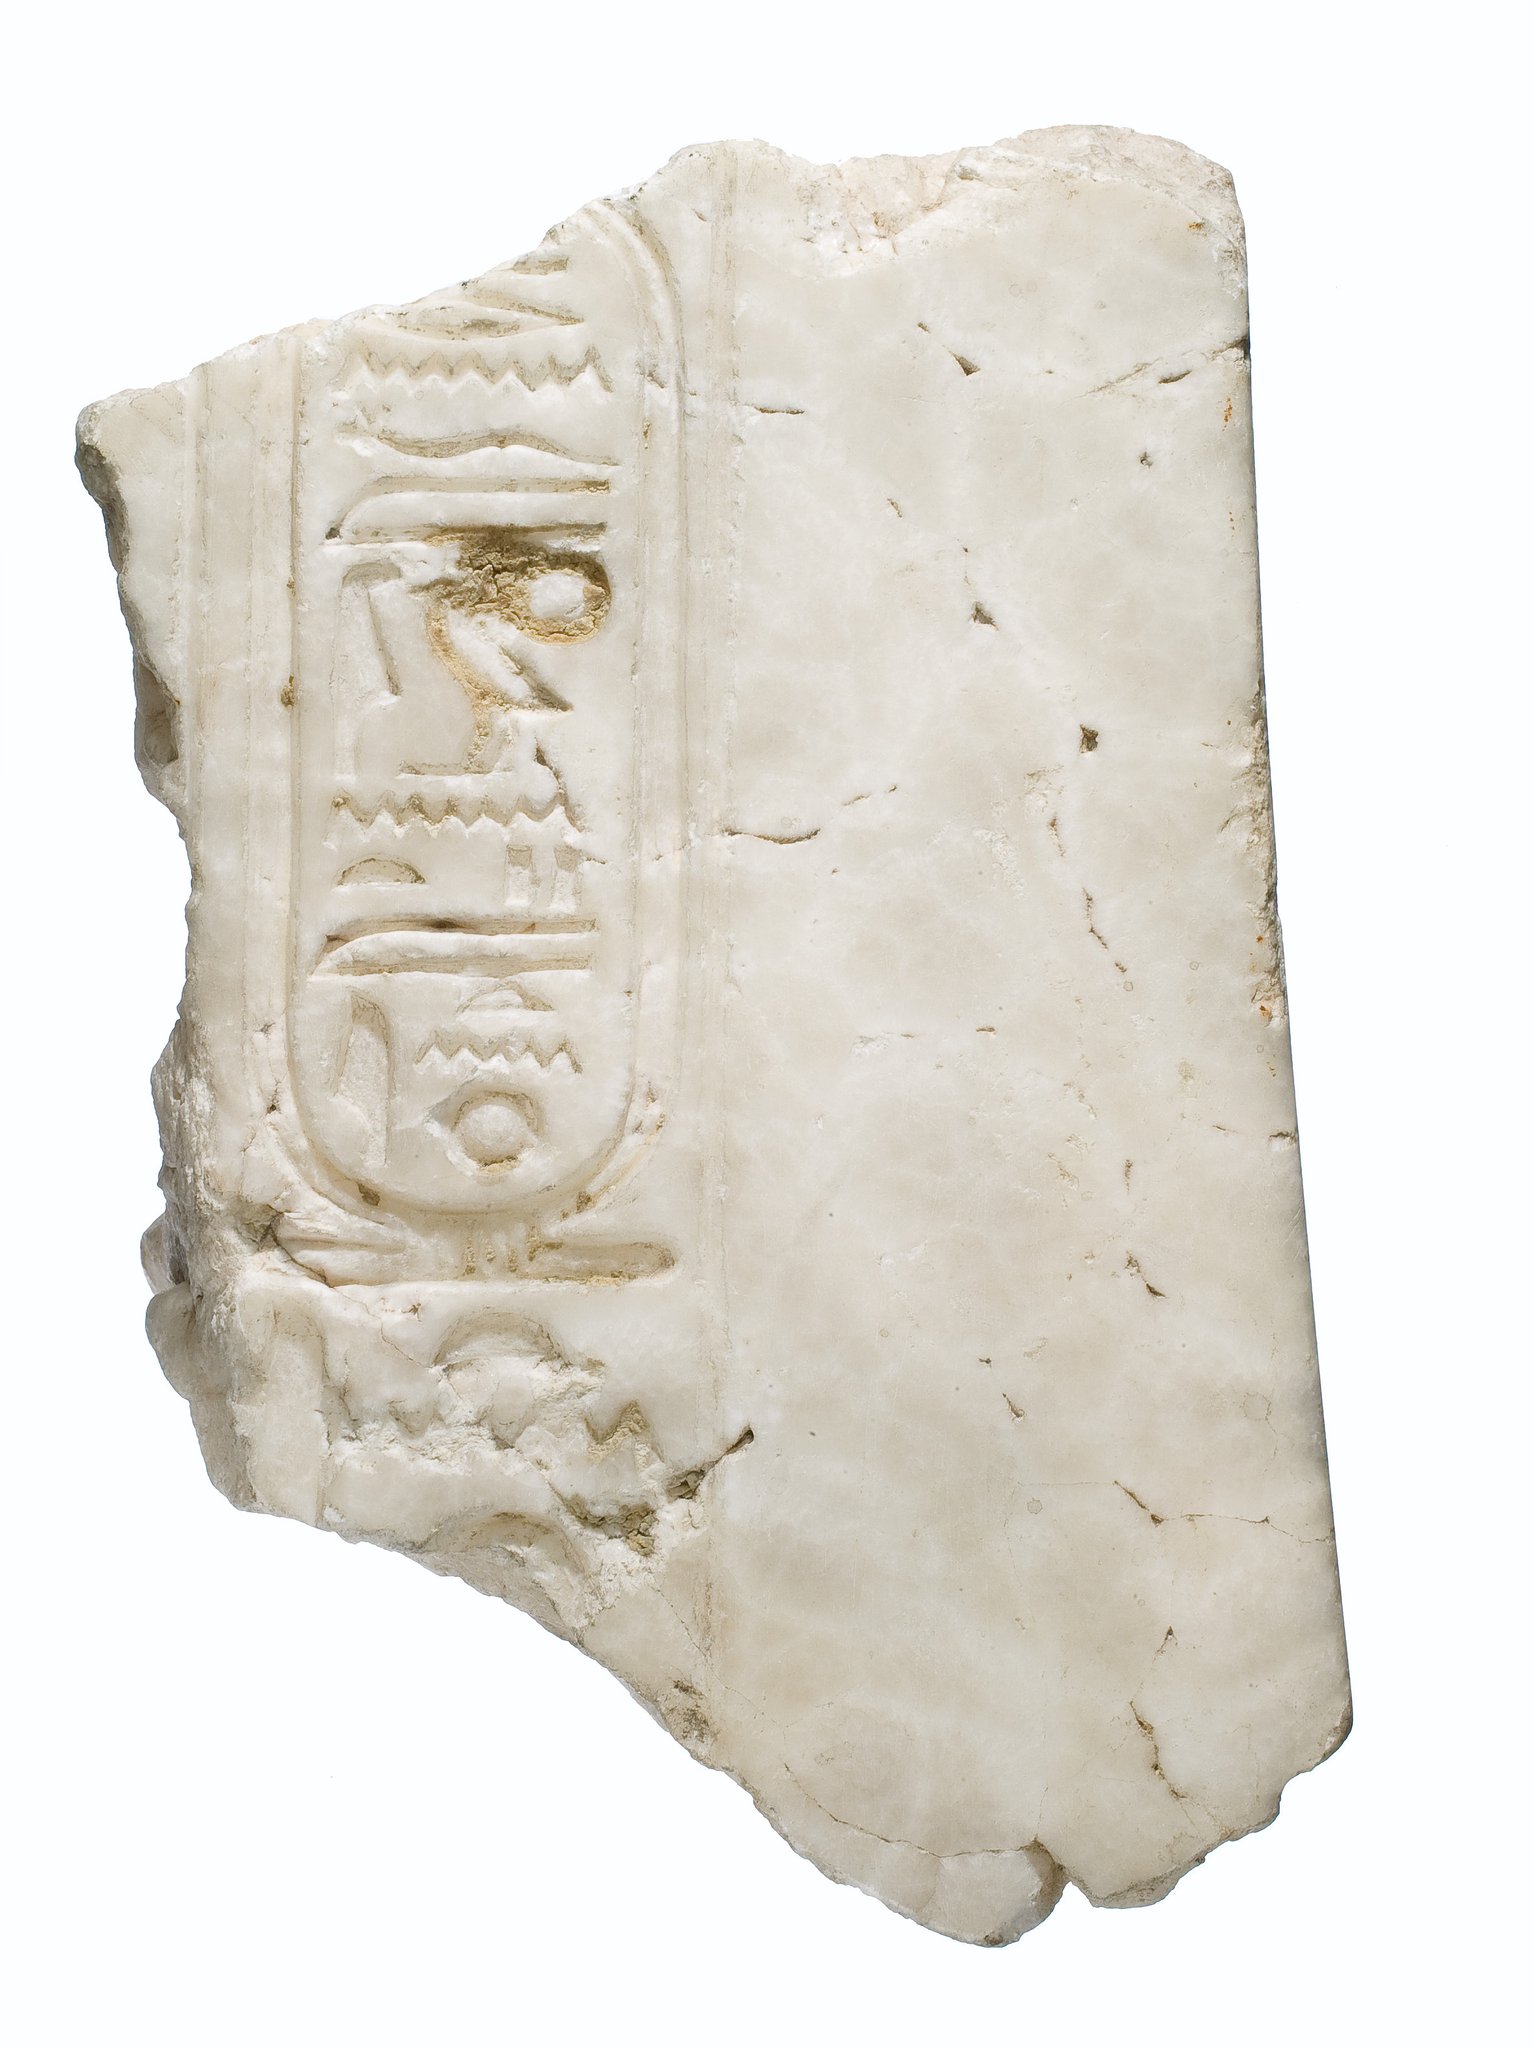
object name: block, cartouche of akhenaten and of aten on opposite side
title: Element with cartouche of Akhenaten and of Aten on opposite sides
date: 1353-1336 BCE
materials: stone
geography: egypt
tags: cartouches,hieroglyphs